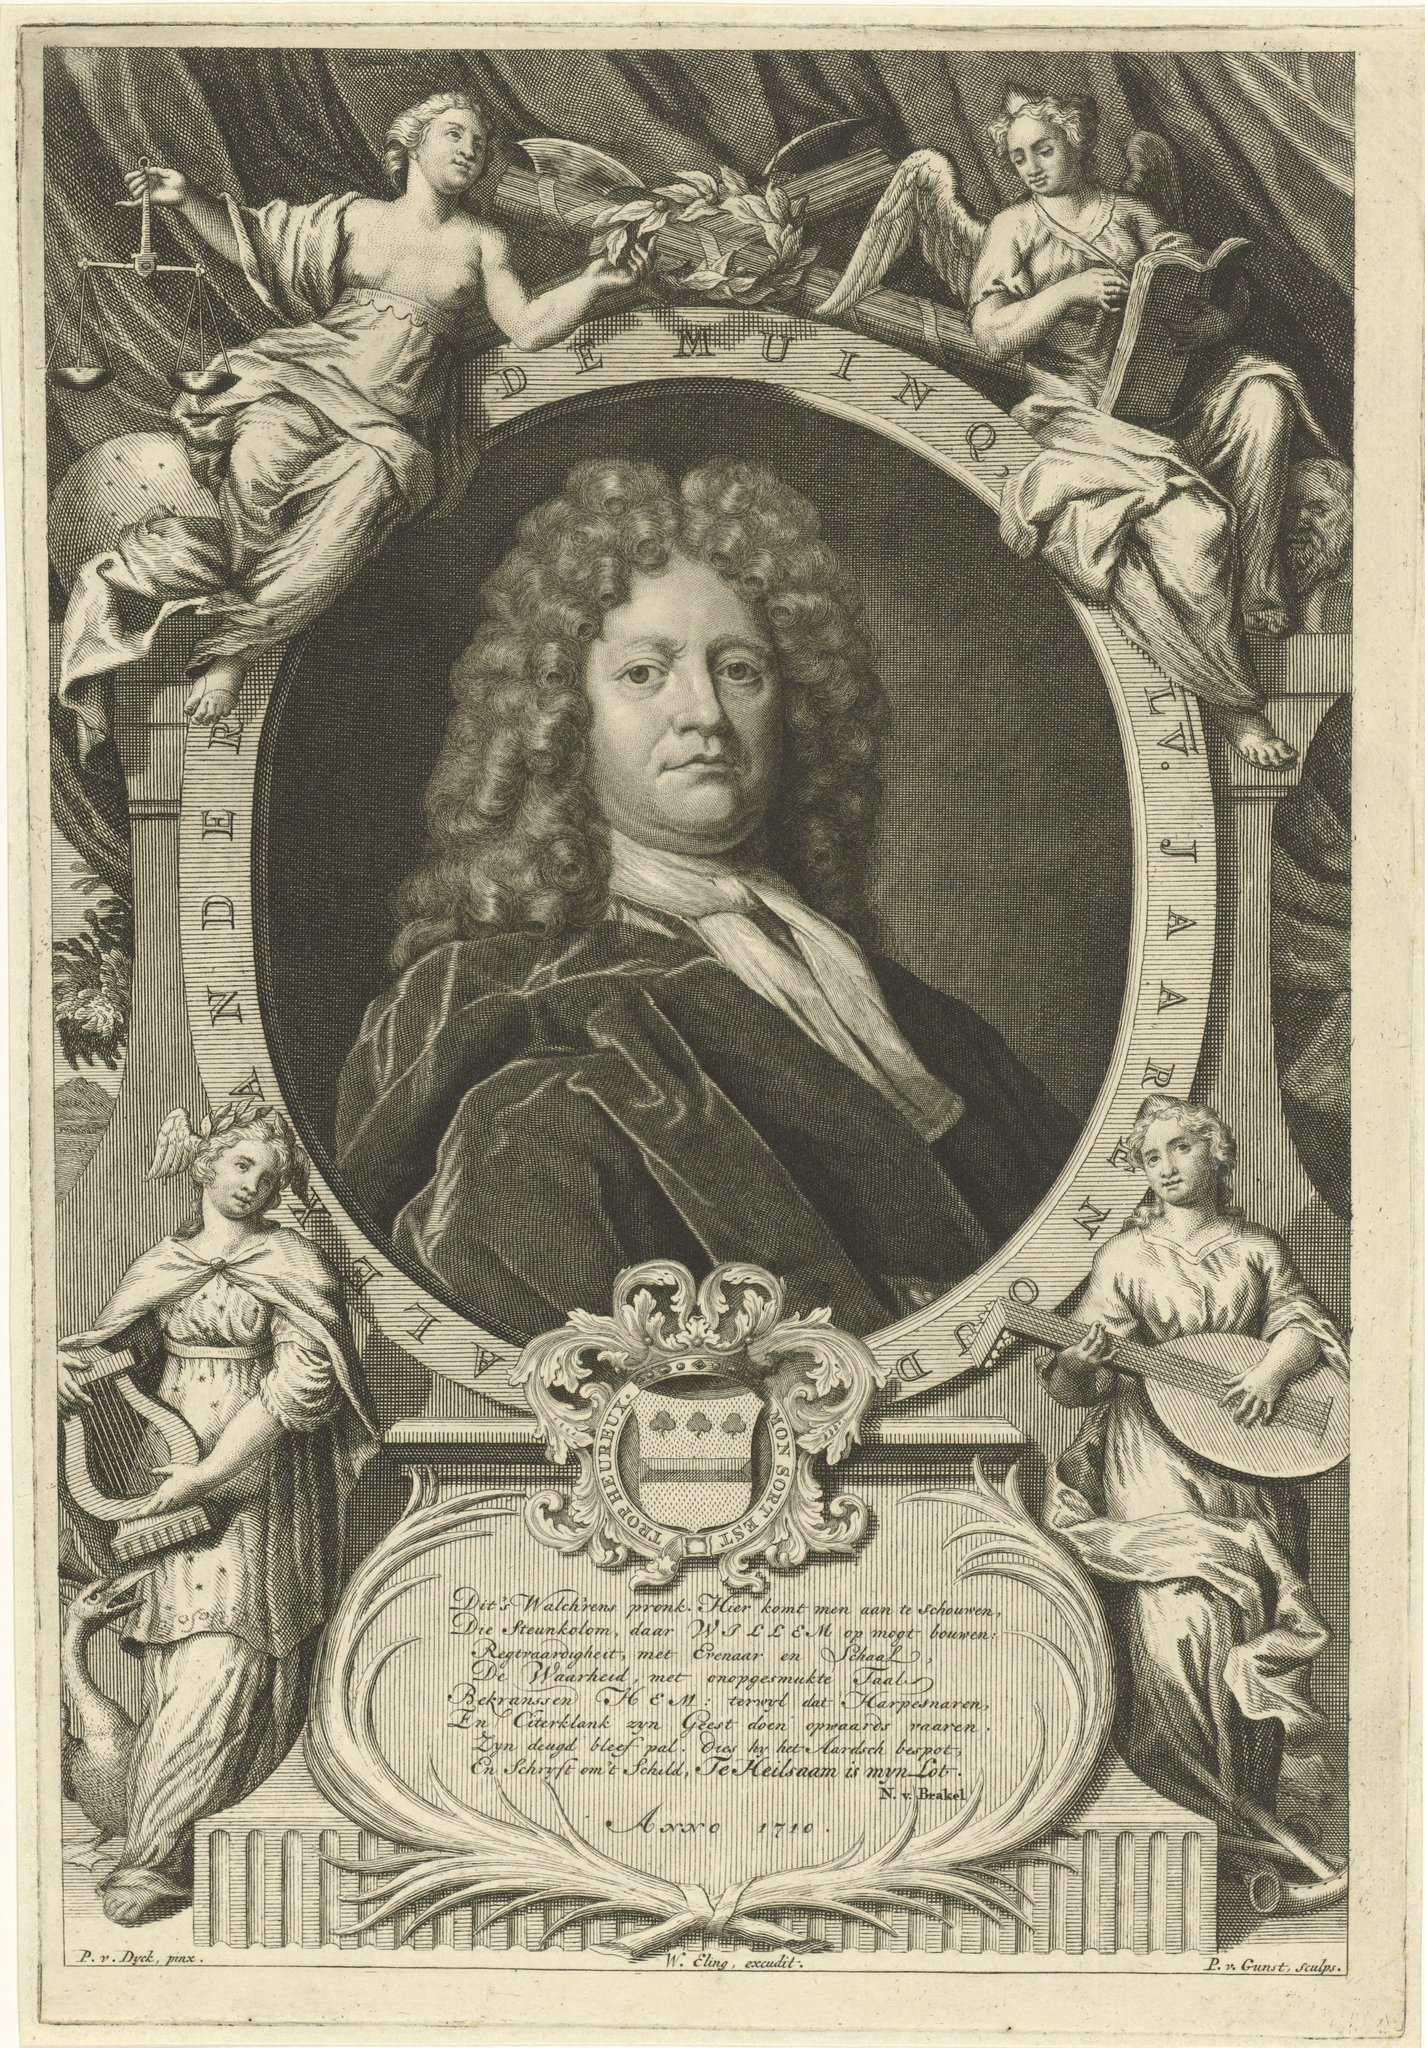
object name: print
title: Portret van Alexander de Muncq op 55-jarige leeftijd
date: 1710-1731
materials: paper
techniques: engraving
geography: amsterdam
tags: making music; musician with instrument, truth; 'verità' (ripa), justice; 'forza alla giustitia sottoposta', 'giustitia', 'giustitia retta', 'giustitia rigorosa', 'impietà e violenza soggetta alla giustitia' (ripa), harp, dulcimer, zither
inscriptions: collector's mark: Lugt 2228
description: Alexander de Muncq, burgemeester van Middelburg en dichter, op 55-jarige leeftijd. Onder het portret zijn wapenschild en een Nederlands gedicht over zijn leven. Boven het portret de personificaties van Rechtvaardigheid en Waarheid, die hem met een lauwerkrans kronen. Onder het portret spelen twee muzen de lier en de citer.